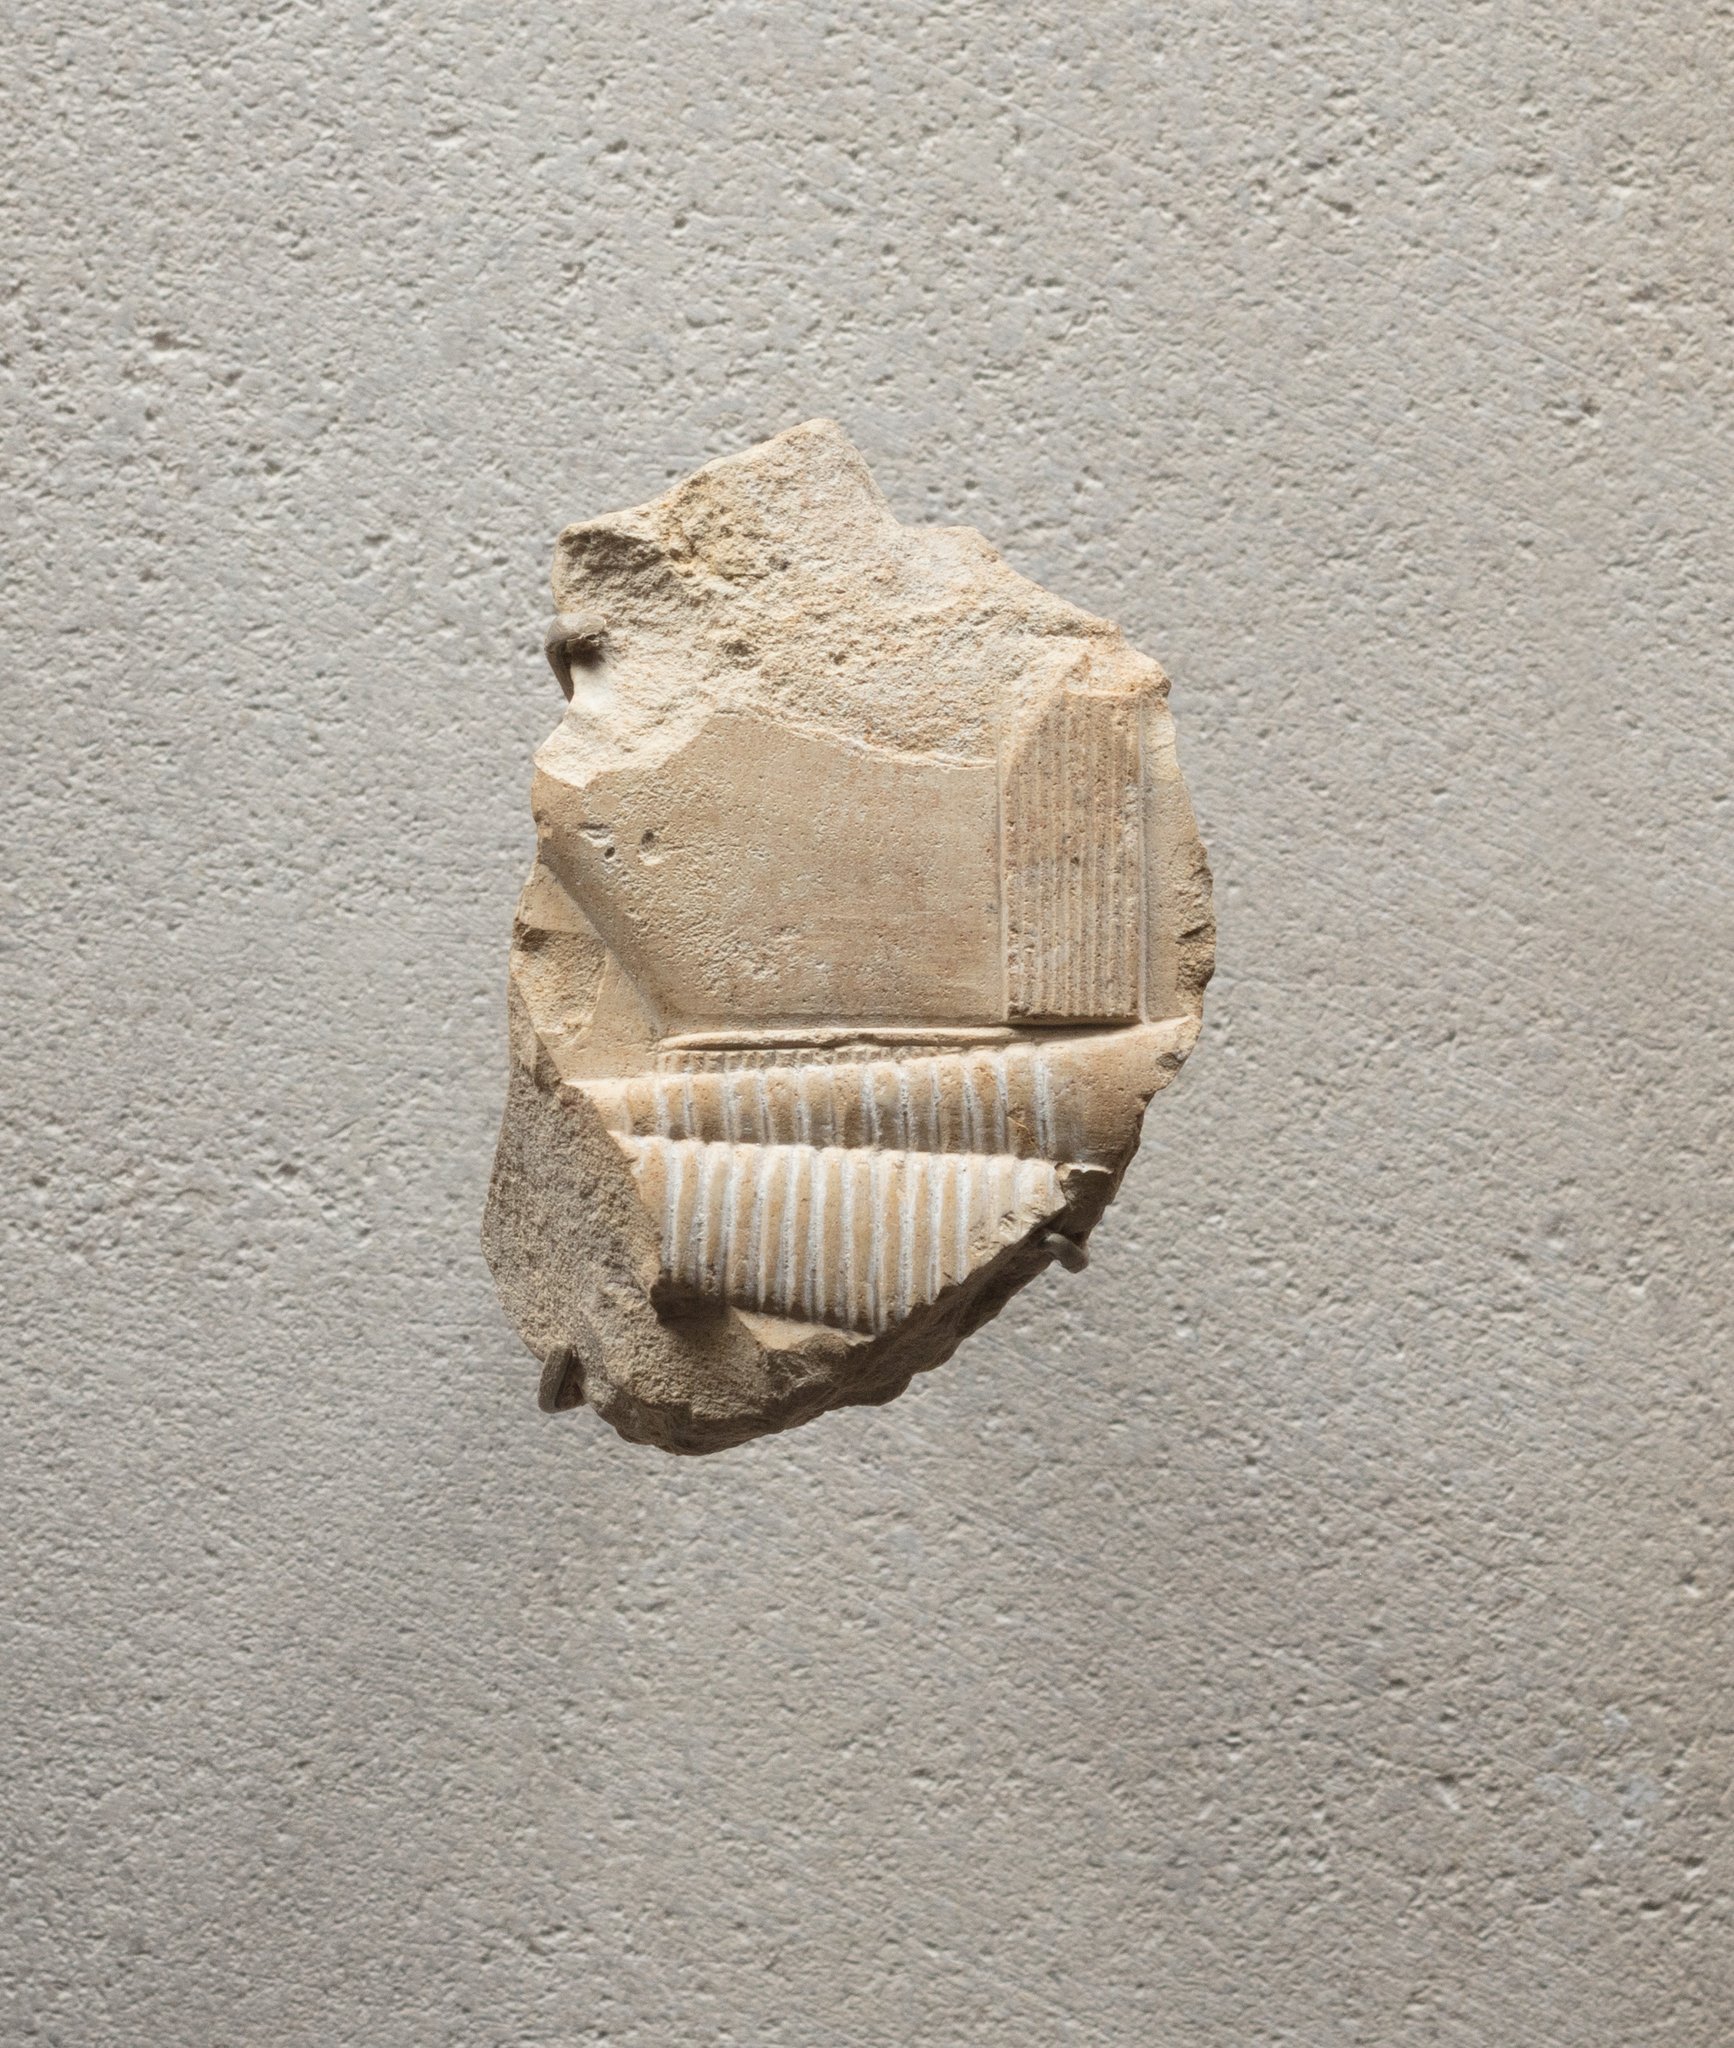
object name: relief, neferu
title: Relief fragment - see 26.3.353-3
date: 2051-2030 BCE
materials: limestone, paint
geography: egypt